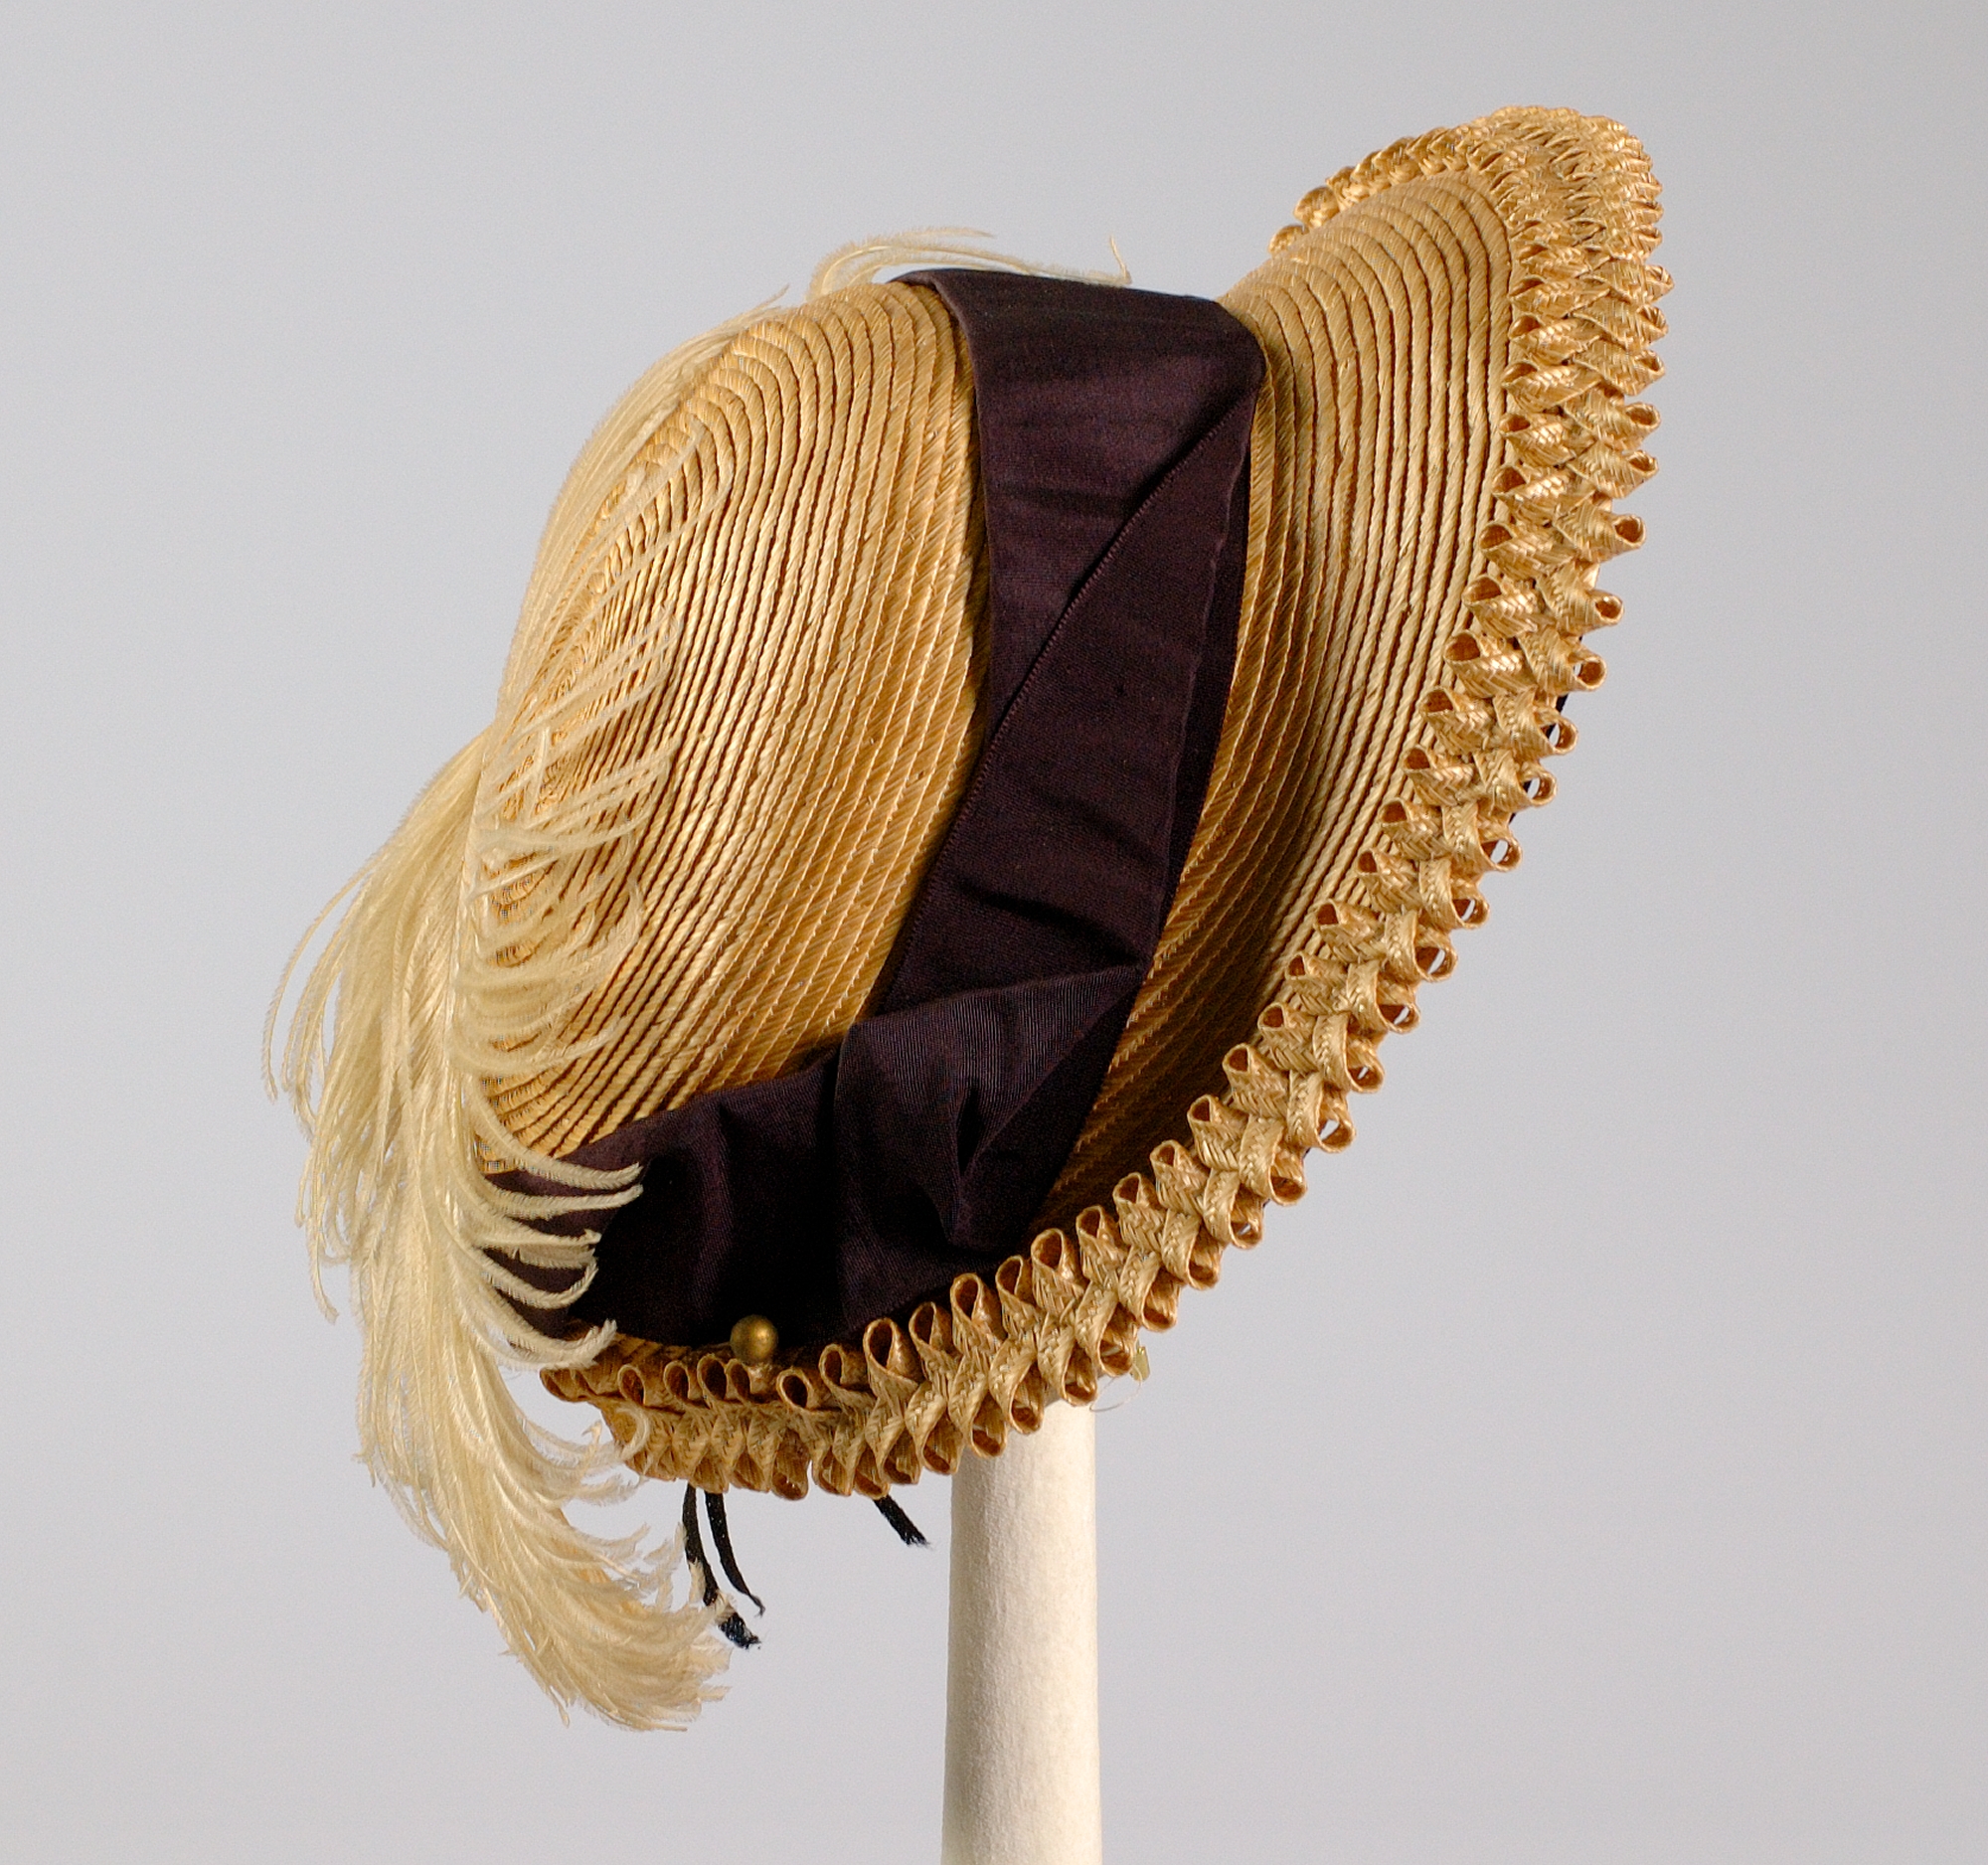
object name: bonnet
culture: american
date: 1890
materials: feather, silk, fiber